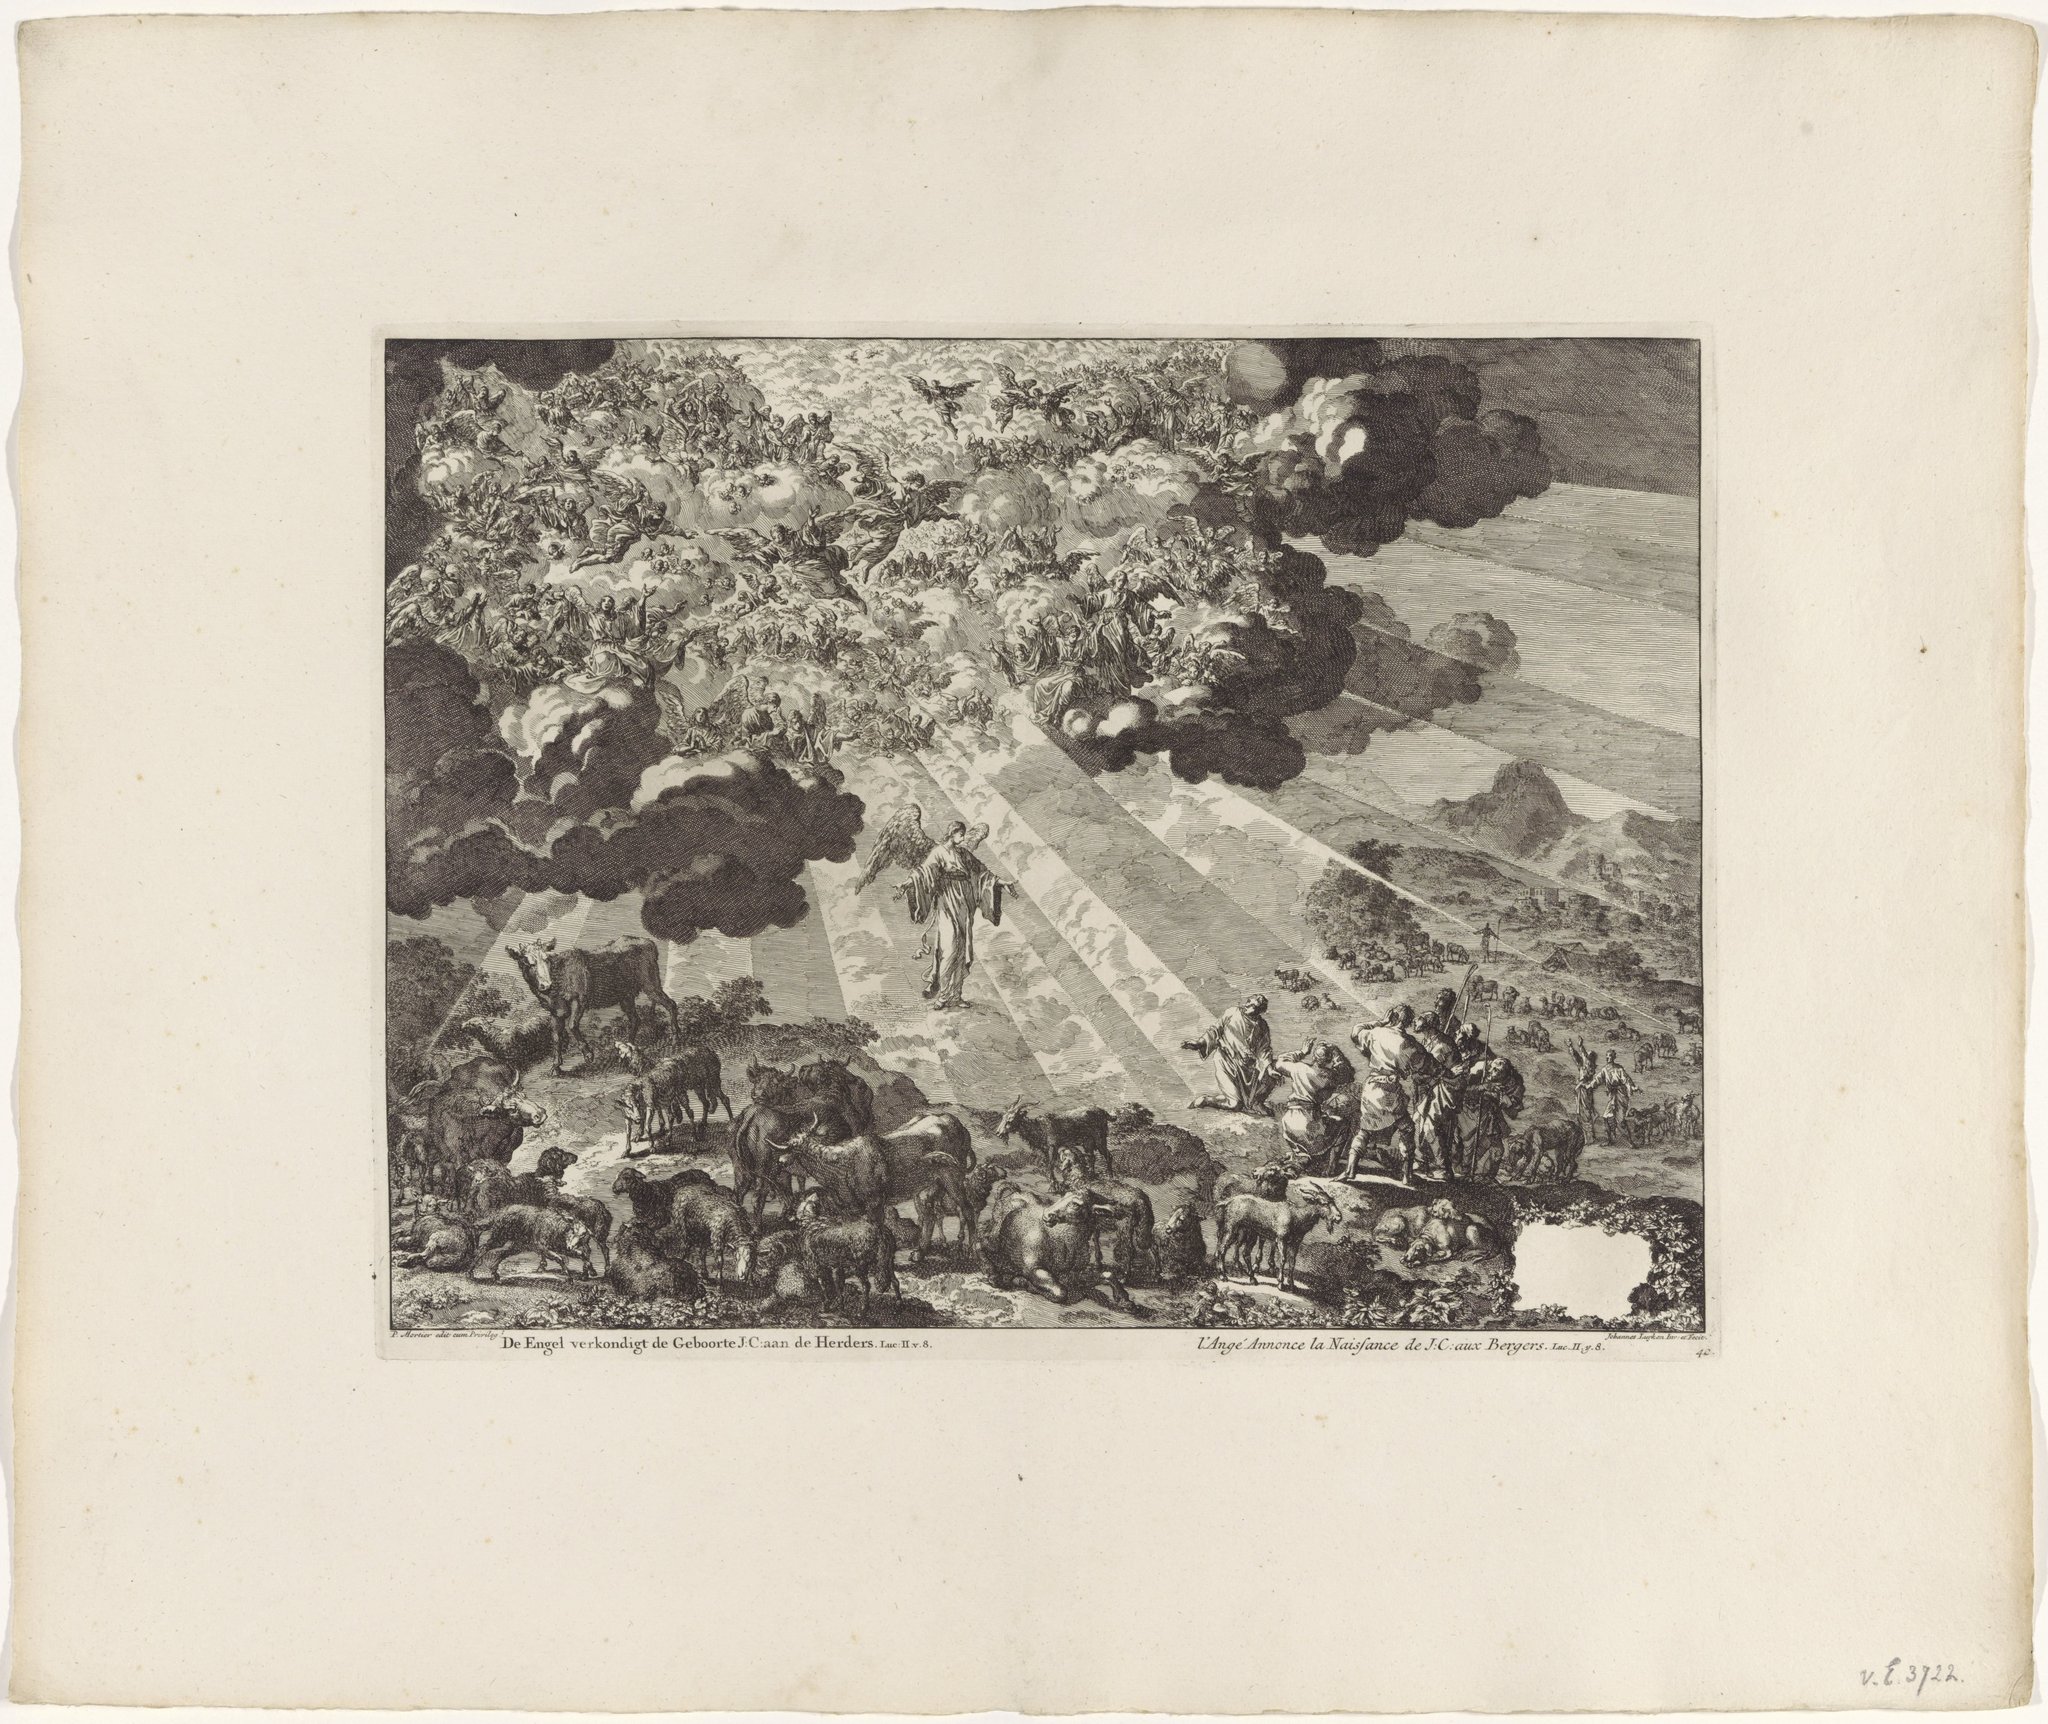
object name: print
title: De Engel verkondigt de Geboorte J.C. aan de Herders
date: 1708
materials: paper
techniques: etching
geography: amsterdam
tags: annunciation of christ's birth to the shepherds (and/or shepherdesses) at night; a host of singing angels in the air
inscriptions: collector's mark: Lugt 2228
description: Een groep herders en hun families worden 's nachts gewekt door een zwerm engelen die in de wolkenhemel verschijnt en de geboorte van Christus aankondigt.